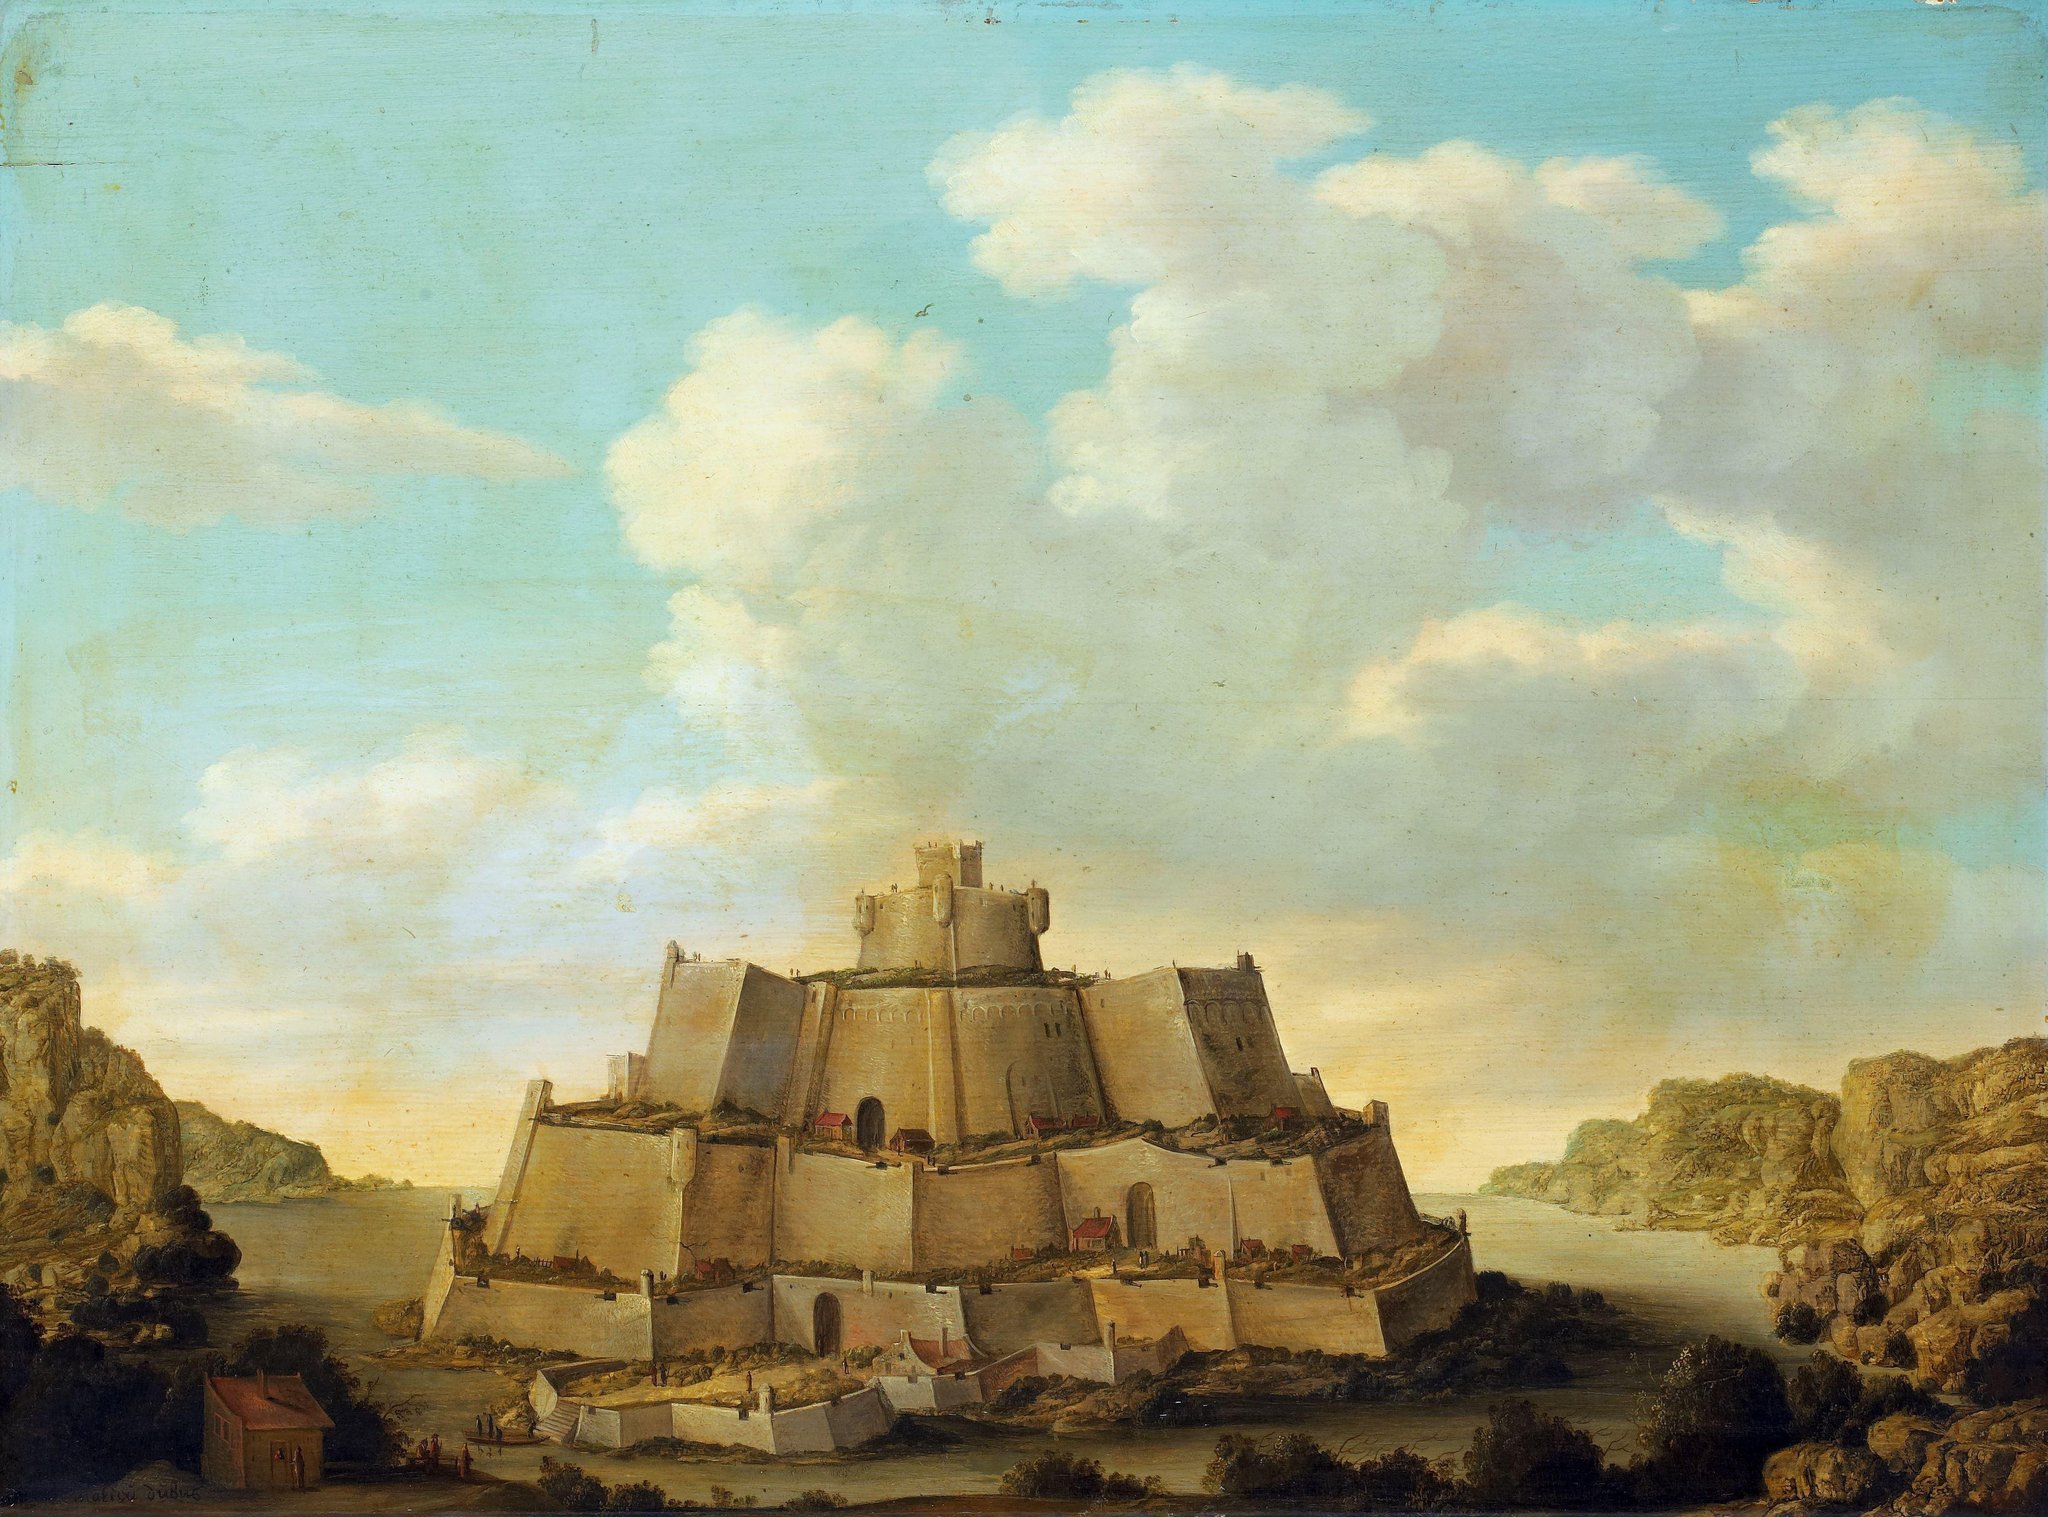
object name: painting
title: A Fortress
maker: mathieu dubus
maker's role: painter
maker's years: 1590-1666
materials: oil, panel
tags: fortress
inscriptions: signature, bottom left: ‘Matioŭ DŭBus’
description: Een fort. Kustlandschap met een vesting op een eiland.